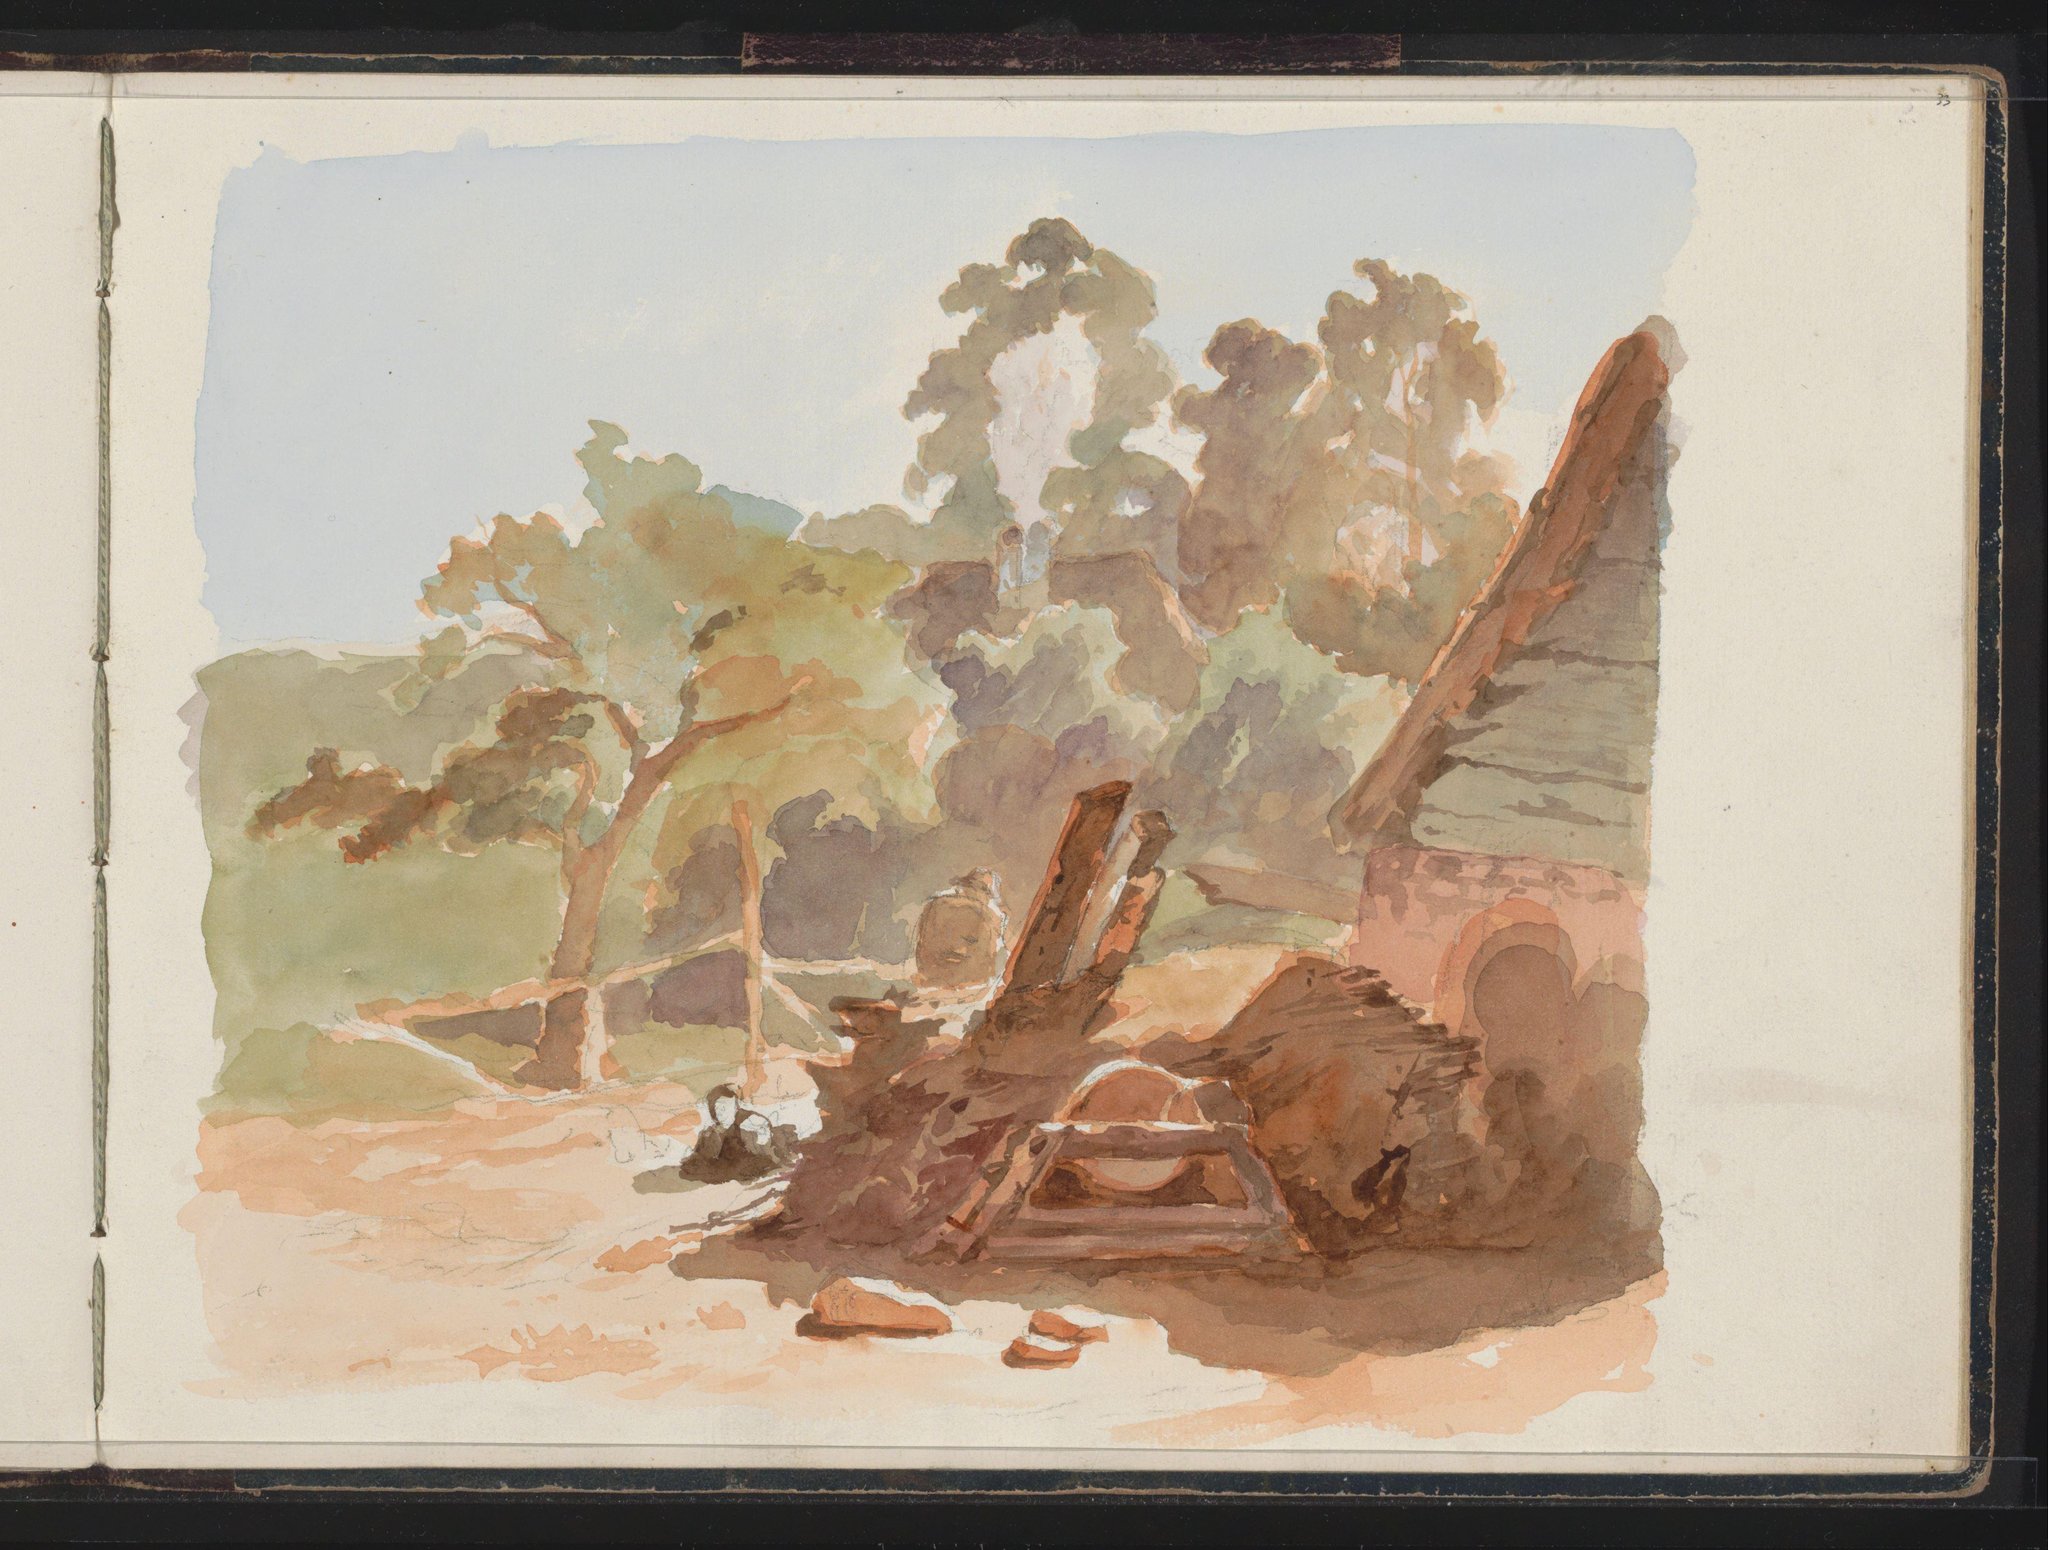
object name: sketchbook leaf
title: Stapel hout voor een hut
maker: maria vos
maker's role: draughtsman, painter, print maker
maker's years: 1824-1906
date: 1864-1865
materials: paper, pencil, watercolor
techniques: brush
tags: wood, timber ~ building material, rural housing, e.g. country-house, villa, cottage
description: Blad 33 recto uit een schetsboek met 44 bladen.